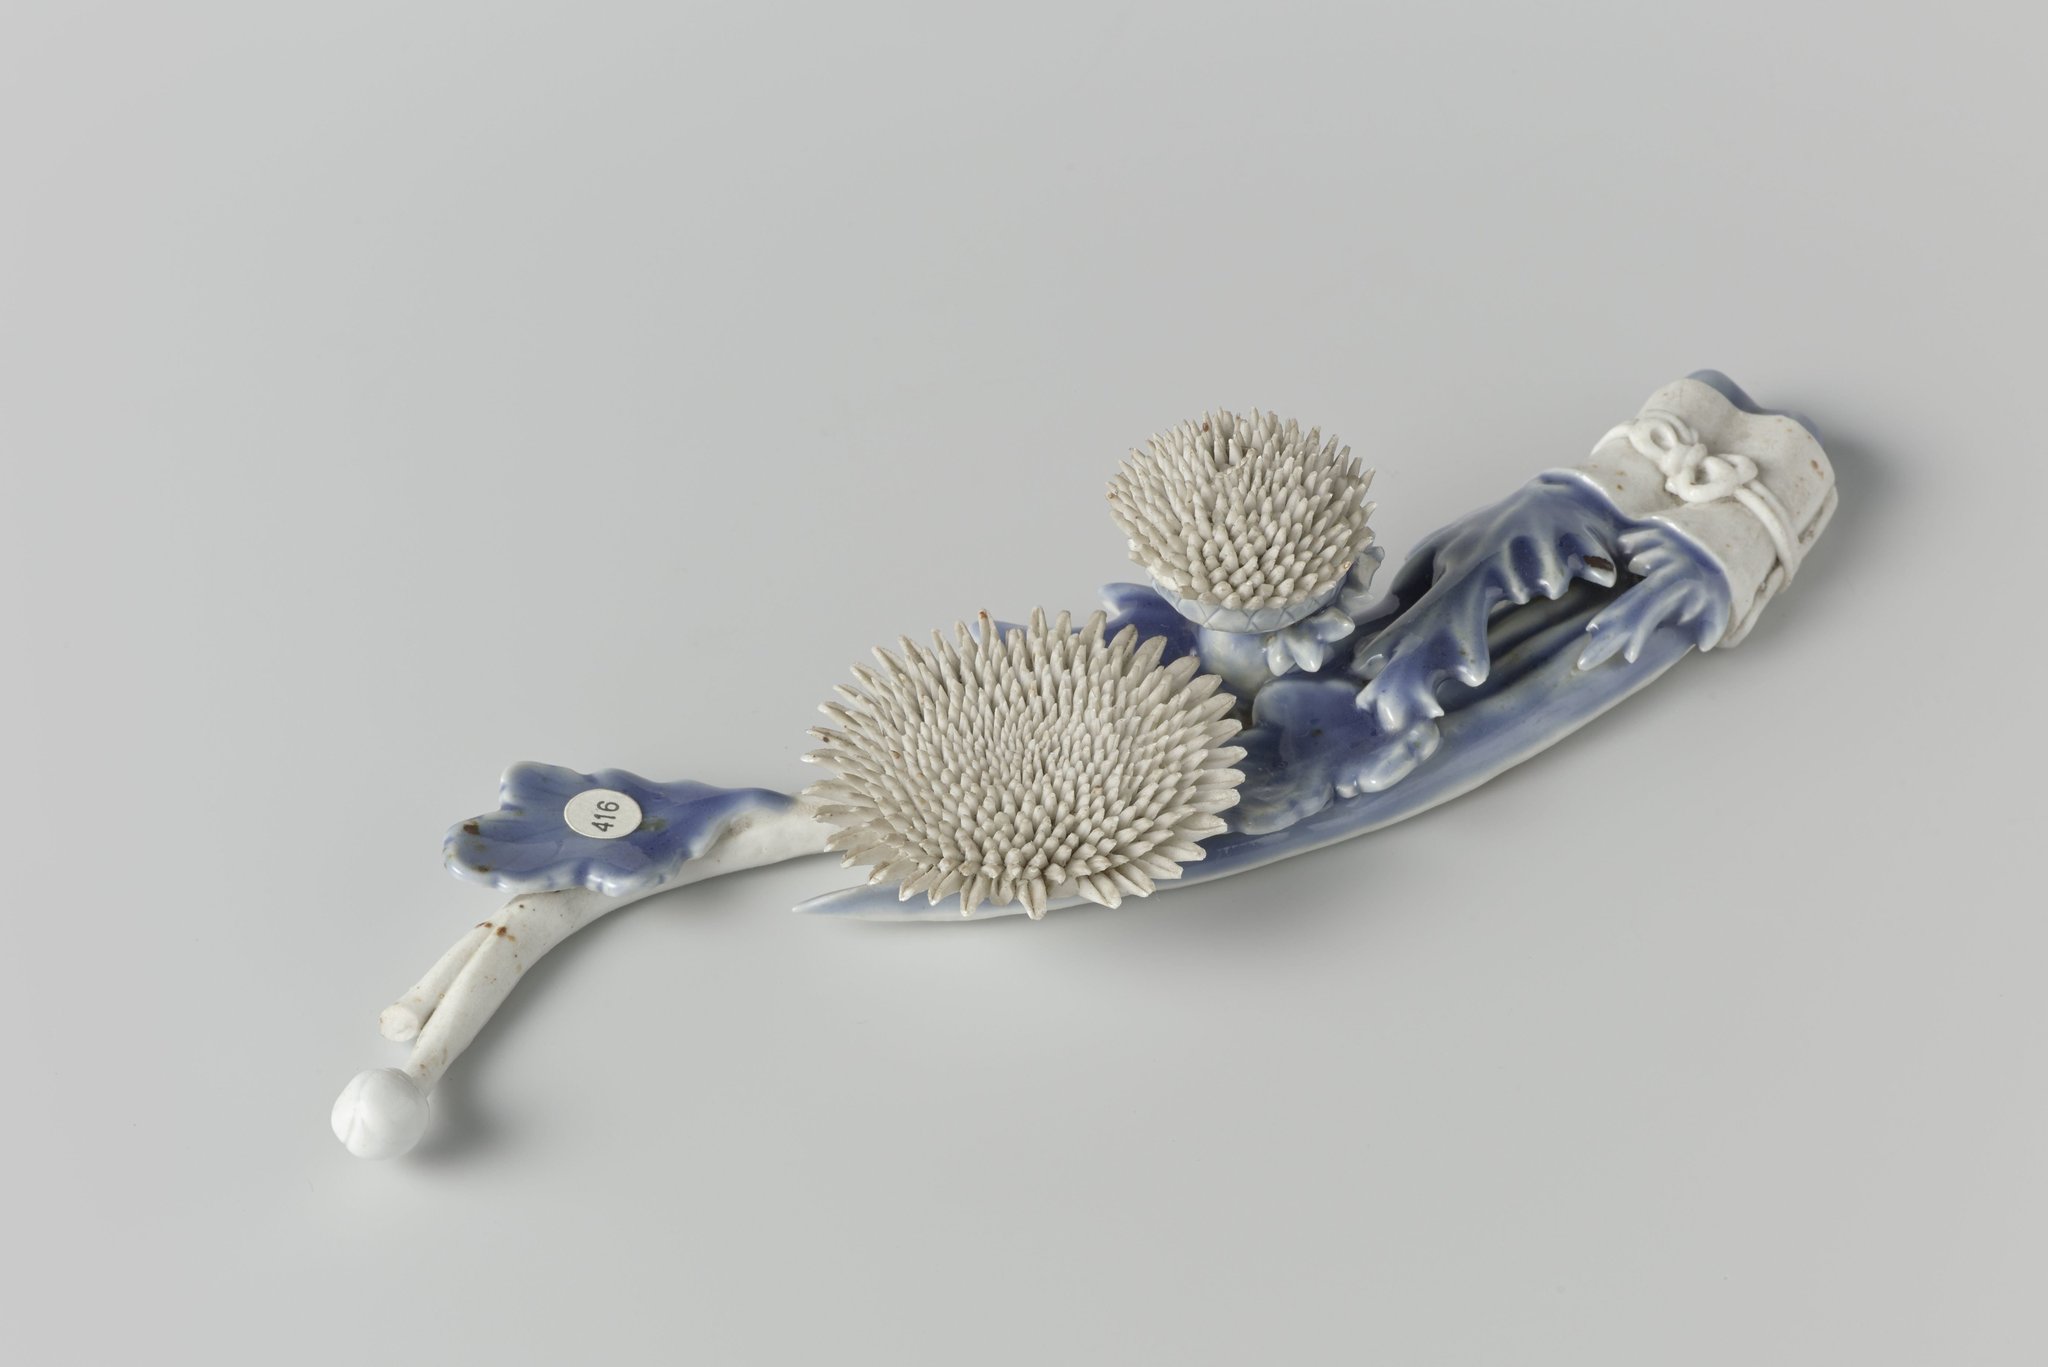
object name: ornament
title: Flower spray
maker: Anonymous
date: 1800-1825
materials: cobalt, glaze, paint, porcelain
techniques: firing, forming, vitrification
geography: japan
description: Bloemtak van porselein bestaande uit drie takken met bladeren, twee bloemen en een knop, bij elkaar gehouden door een lint. Gedeeltelijk bedekt met onderglazuur blauw. Onderglazuur blauw met biscuit.